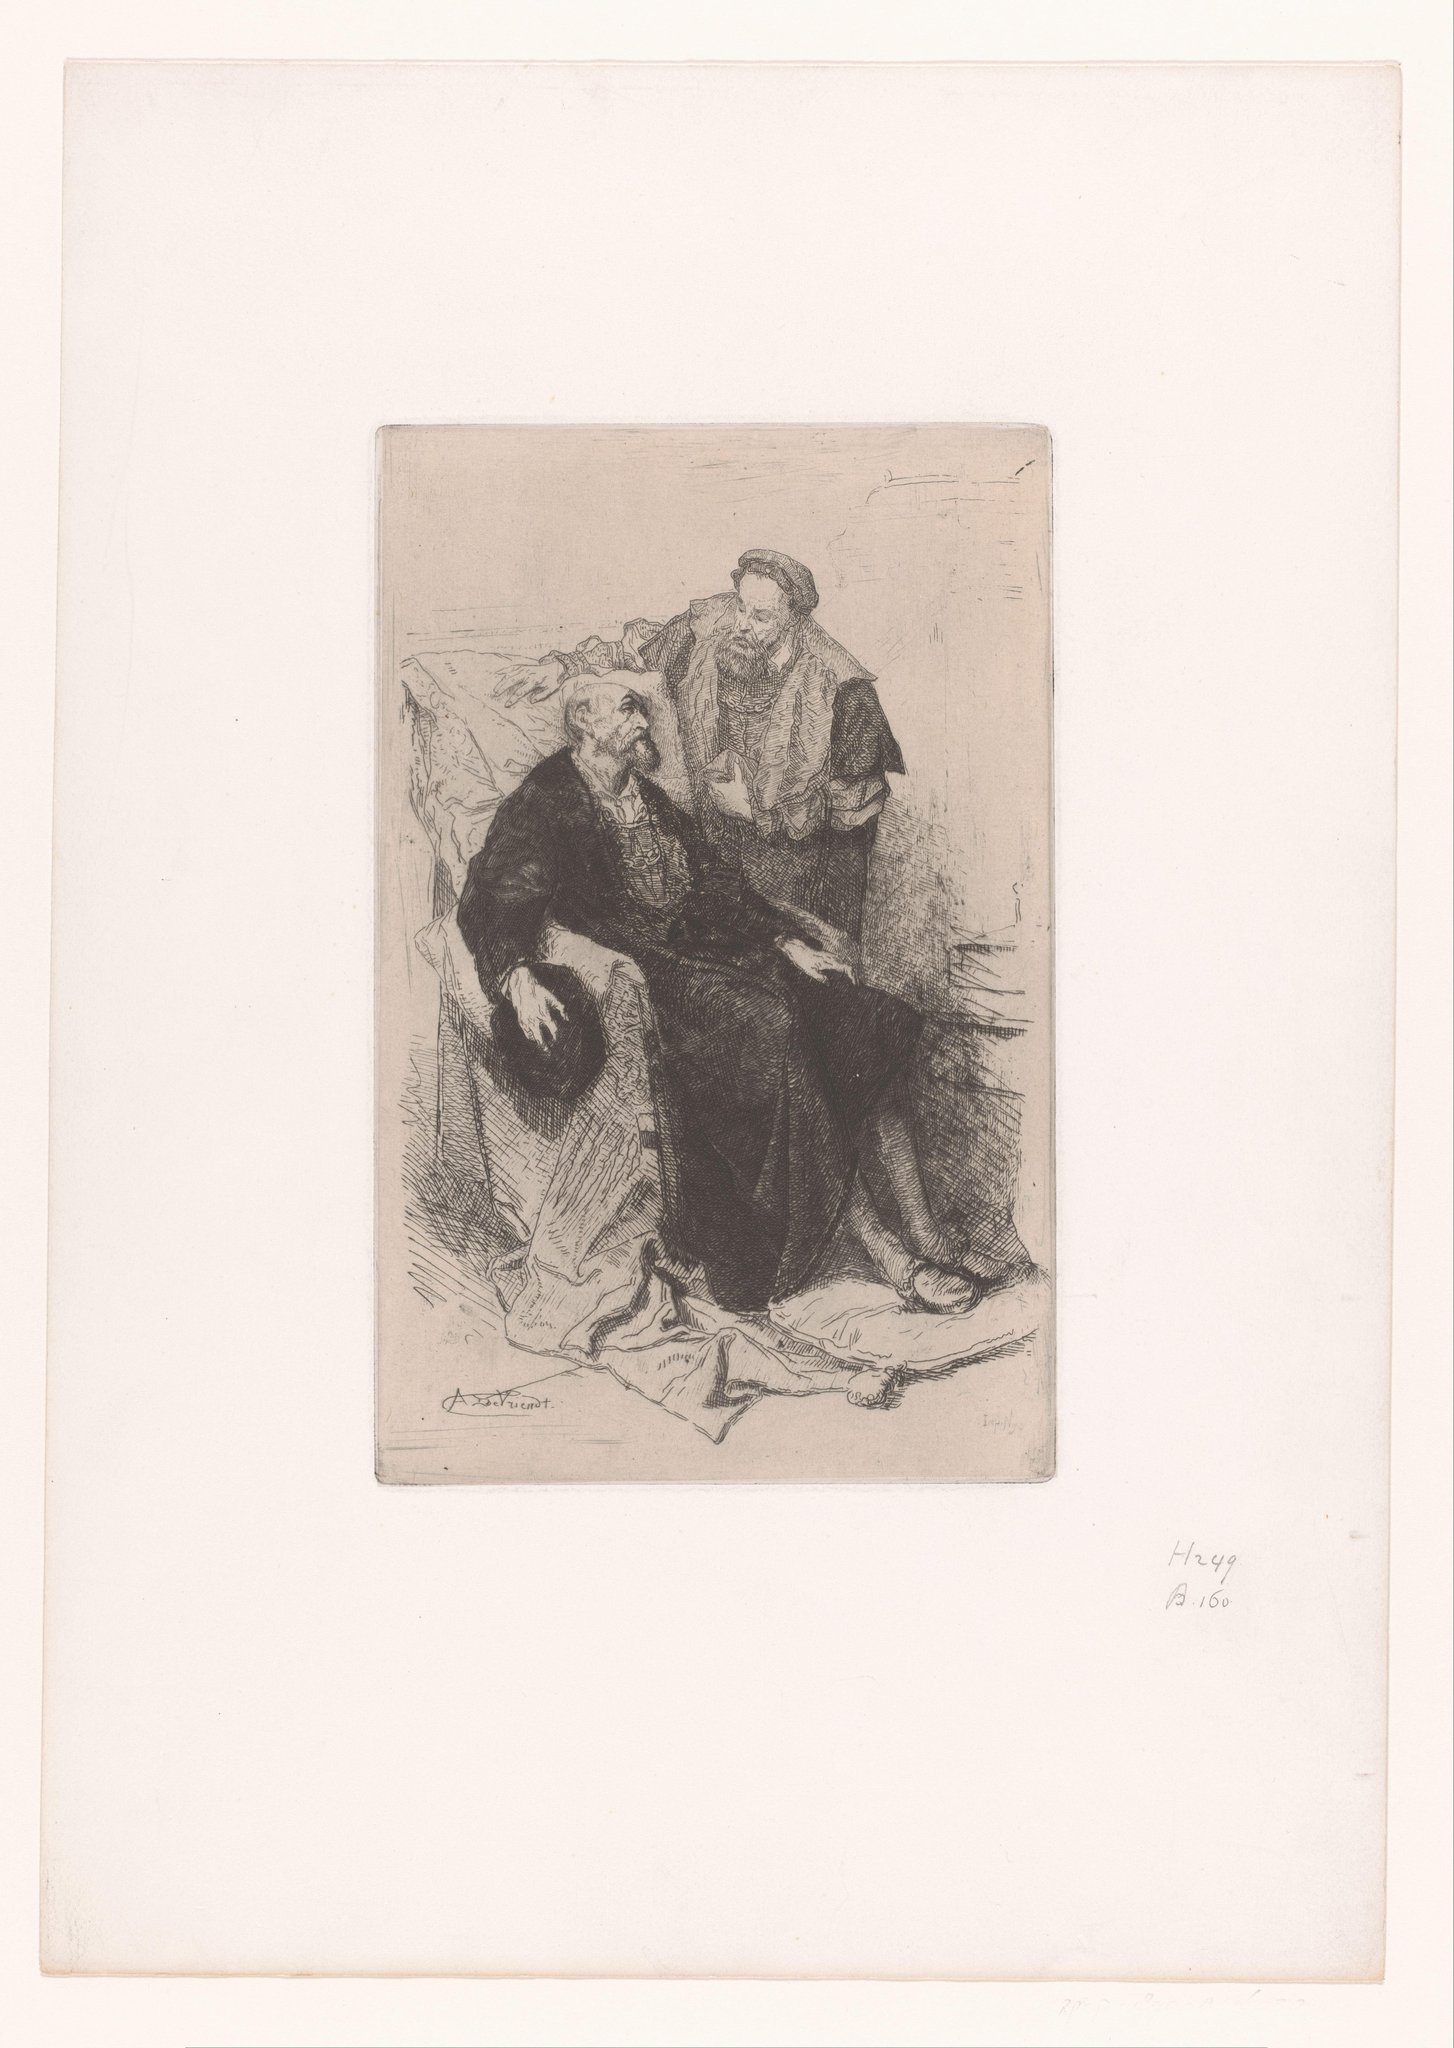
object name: print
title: Man staand bij de oude keizer Karel V gezeten in een leunstoel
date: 1876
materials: paper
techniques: etching, retroussage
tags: ghent, charles v (holy roman emperor and king of spain), armchair, seat, adult man, old man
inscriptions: collector's mark: Lugt 2228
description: Prent verschenen in: Album du journal des Beaux-Arts, dix eaux-fortes inédites. Brussel, Parijs en Leipzig: S.n., 1876. Op voorblad van de publicatie getiteld: Les derniers jours de Charles Quint.